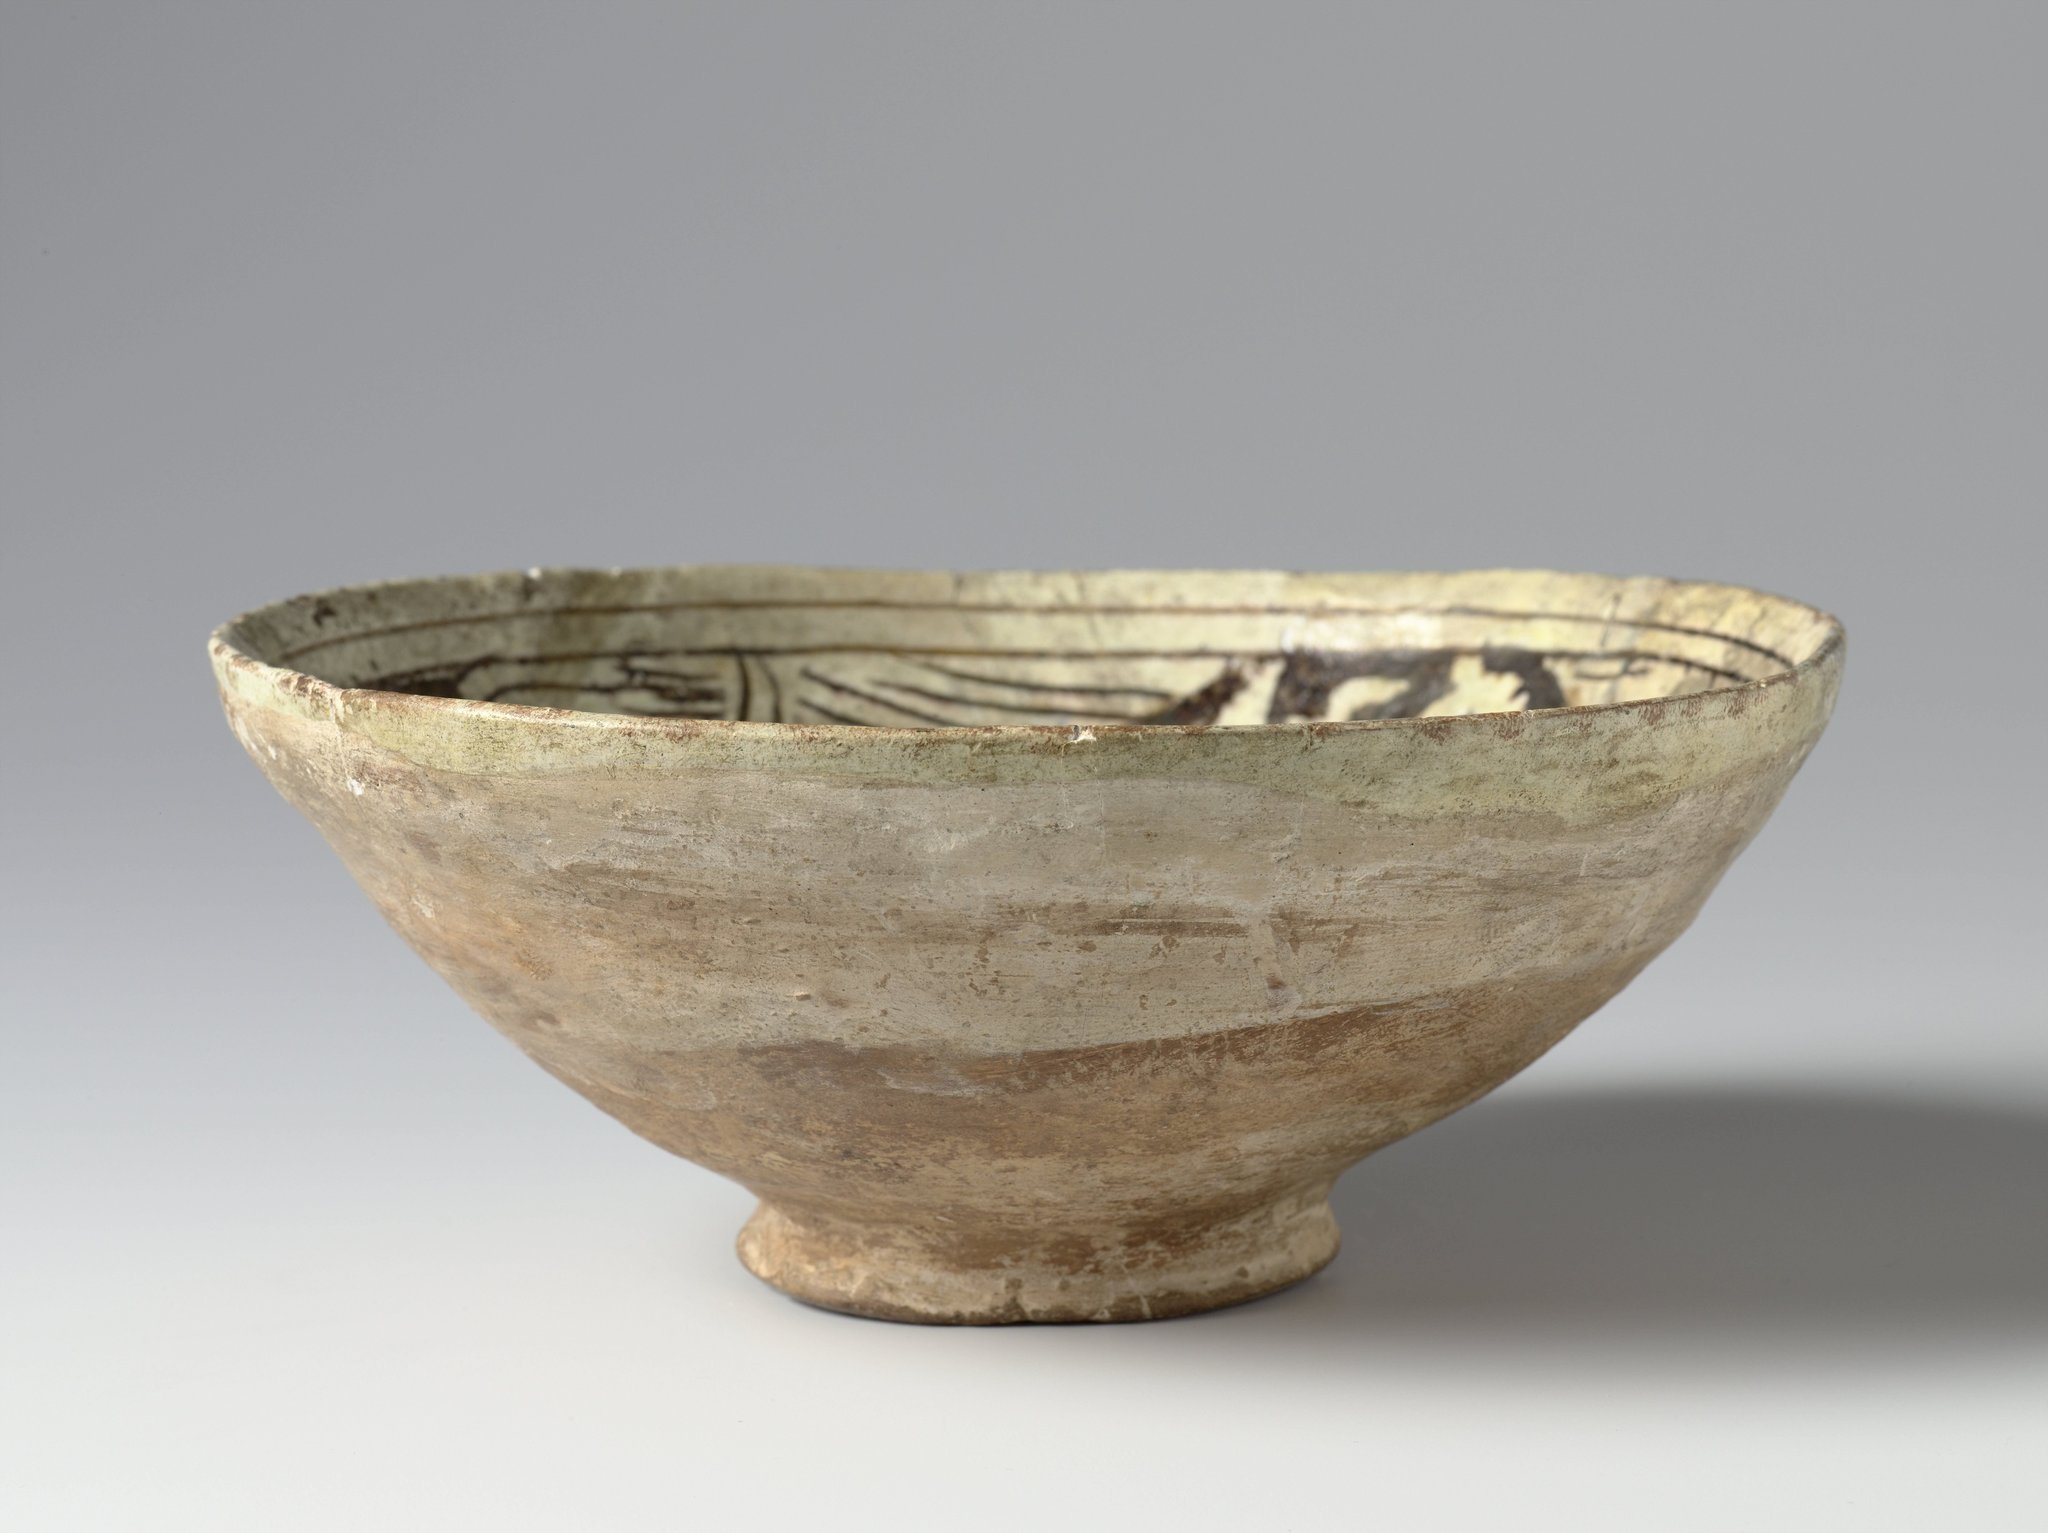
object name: bowl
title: Bowl with three stylized birds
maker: Anonymous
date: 1100-1299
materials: earthenware, glaze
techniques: cutting, firing, turning, vitrification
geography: garrus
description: Bowl. Iran, Garrus district, 12th - 13th century. Earthenware. Three eagles are cut into the slip on the inside of the bowl. Given by Prof. Dr J.A. Oosterbaan and Mrs Oosterbaan-Lugt.